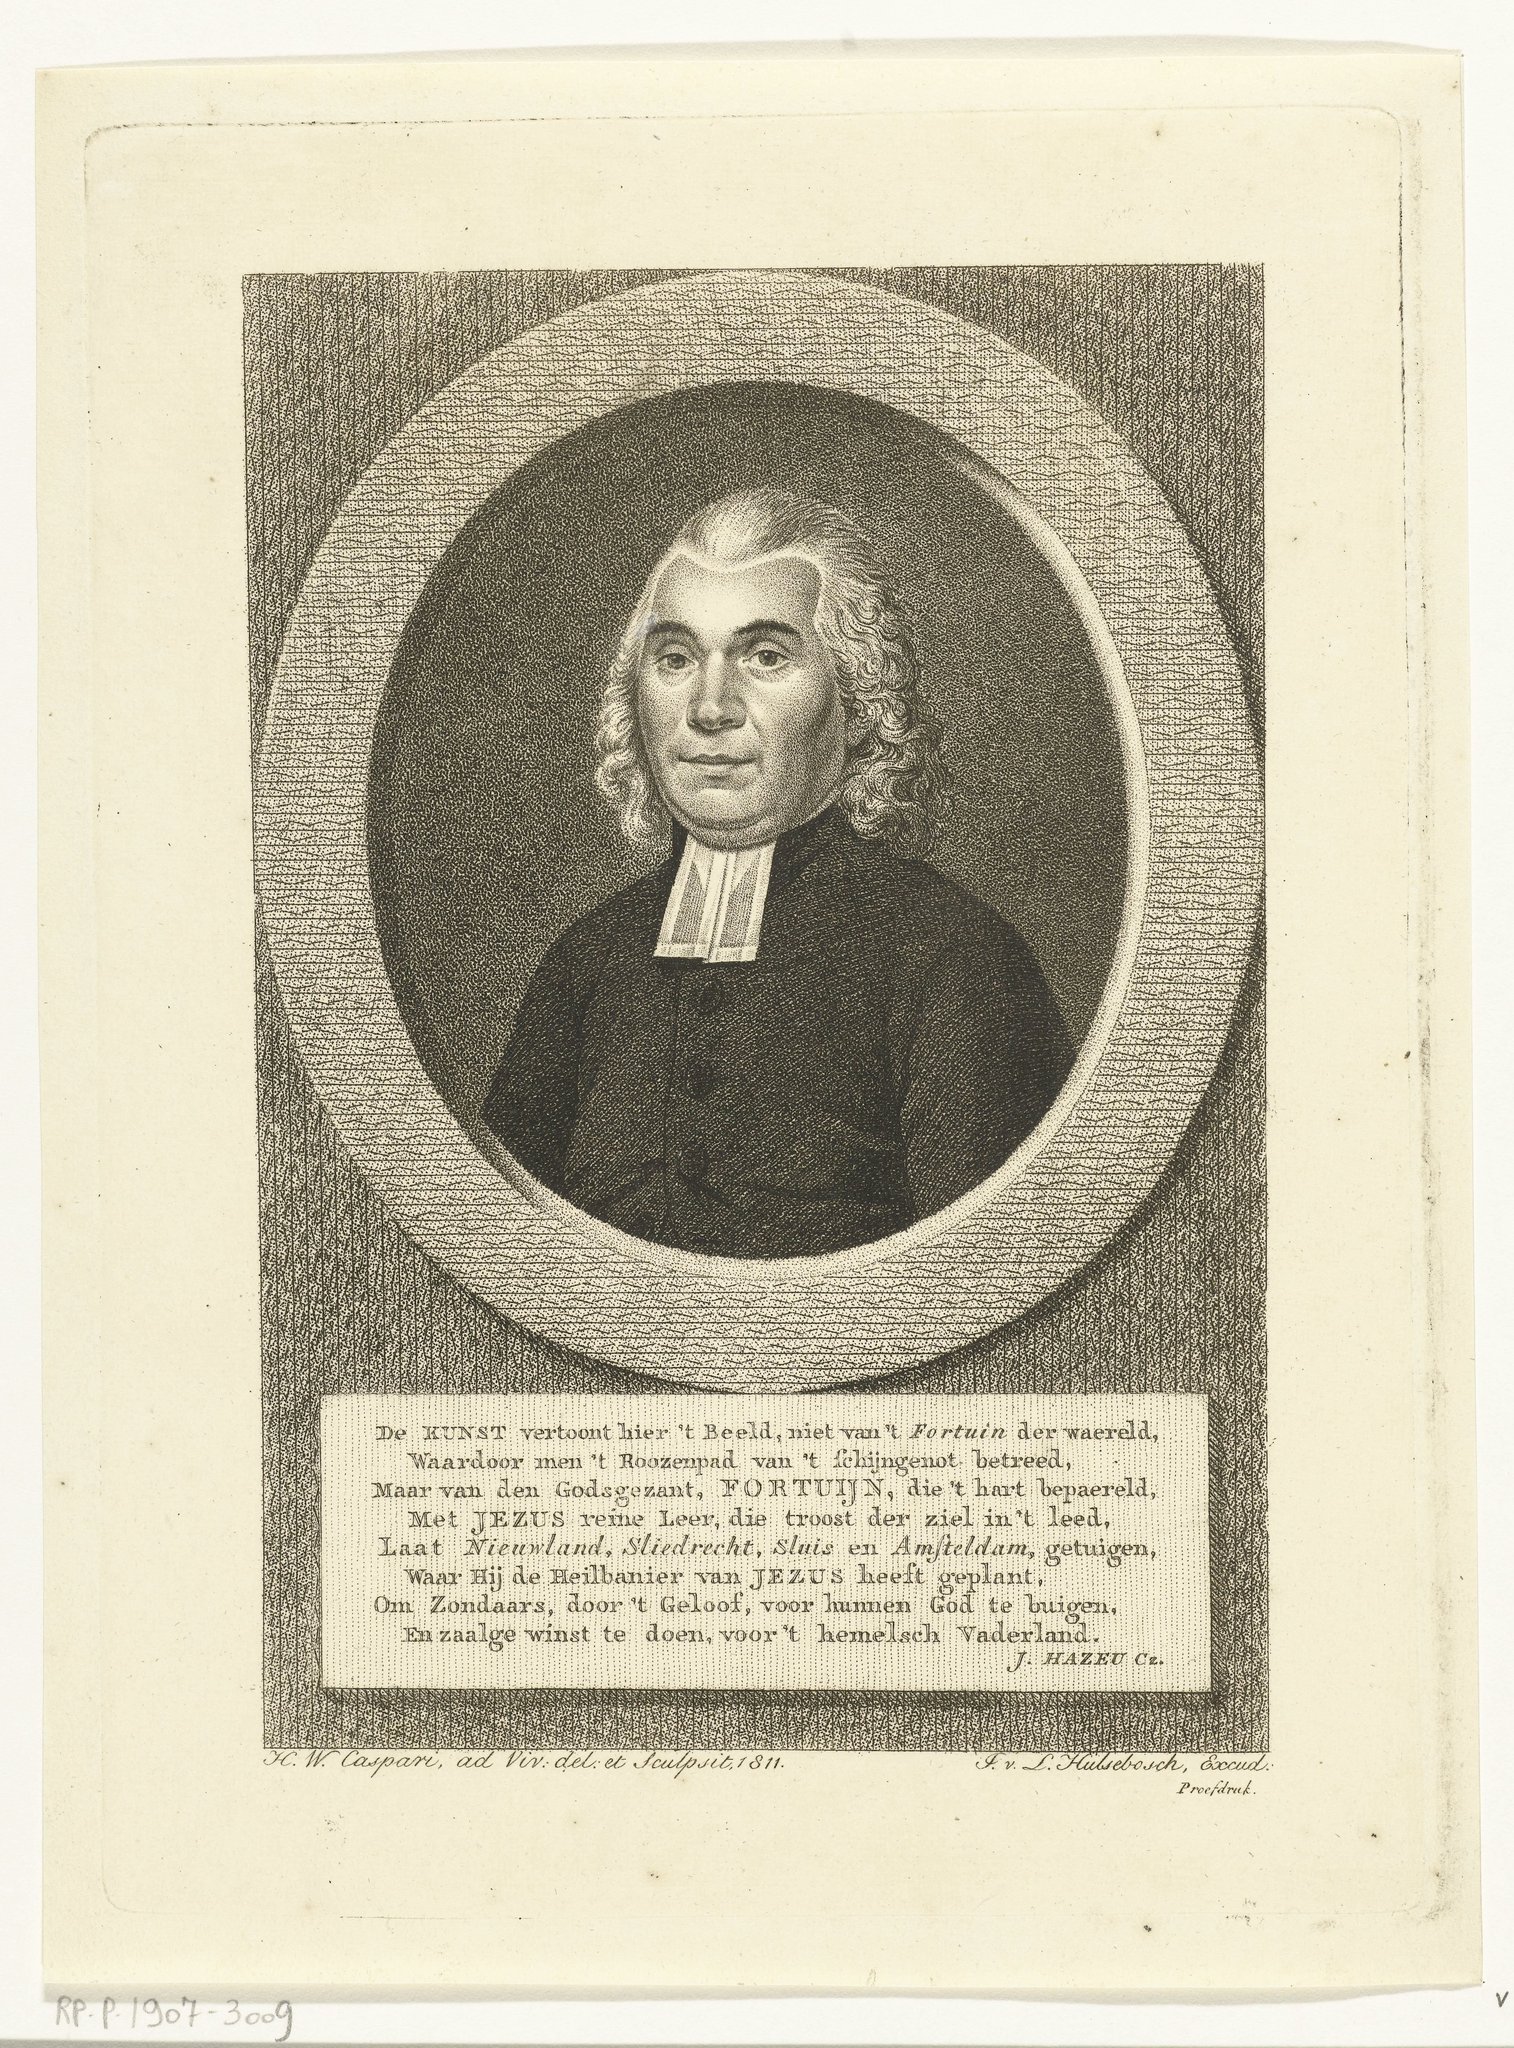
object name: print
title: Portret van Cornelis Fortuyn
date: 1811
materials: paper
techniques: etching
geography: amsterdam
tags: prediker, cornelis fortuyn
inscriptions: collector's mark: Lugt 2228, inscription: ‘Proefdruk’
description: Portret in ovale lijst van Cornelis Fortuyn, een Amsterdamse prediker. Buste naar links. Fortuyn draagt een predikersgewaad. De prent heeft een Nederlands onderschrift met de naam van de geportretteerde en een gedicht van Johannes Hazeu.